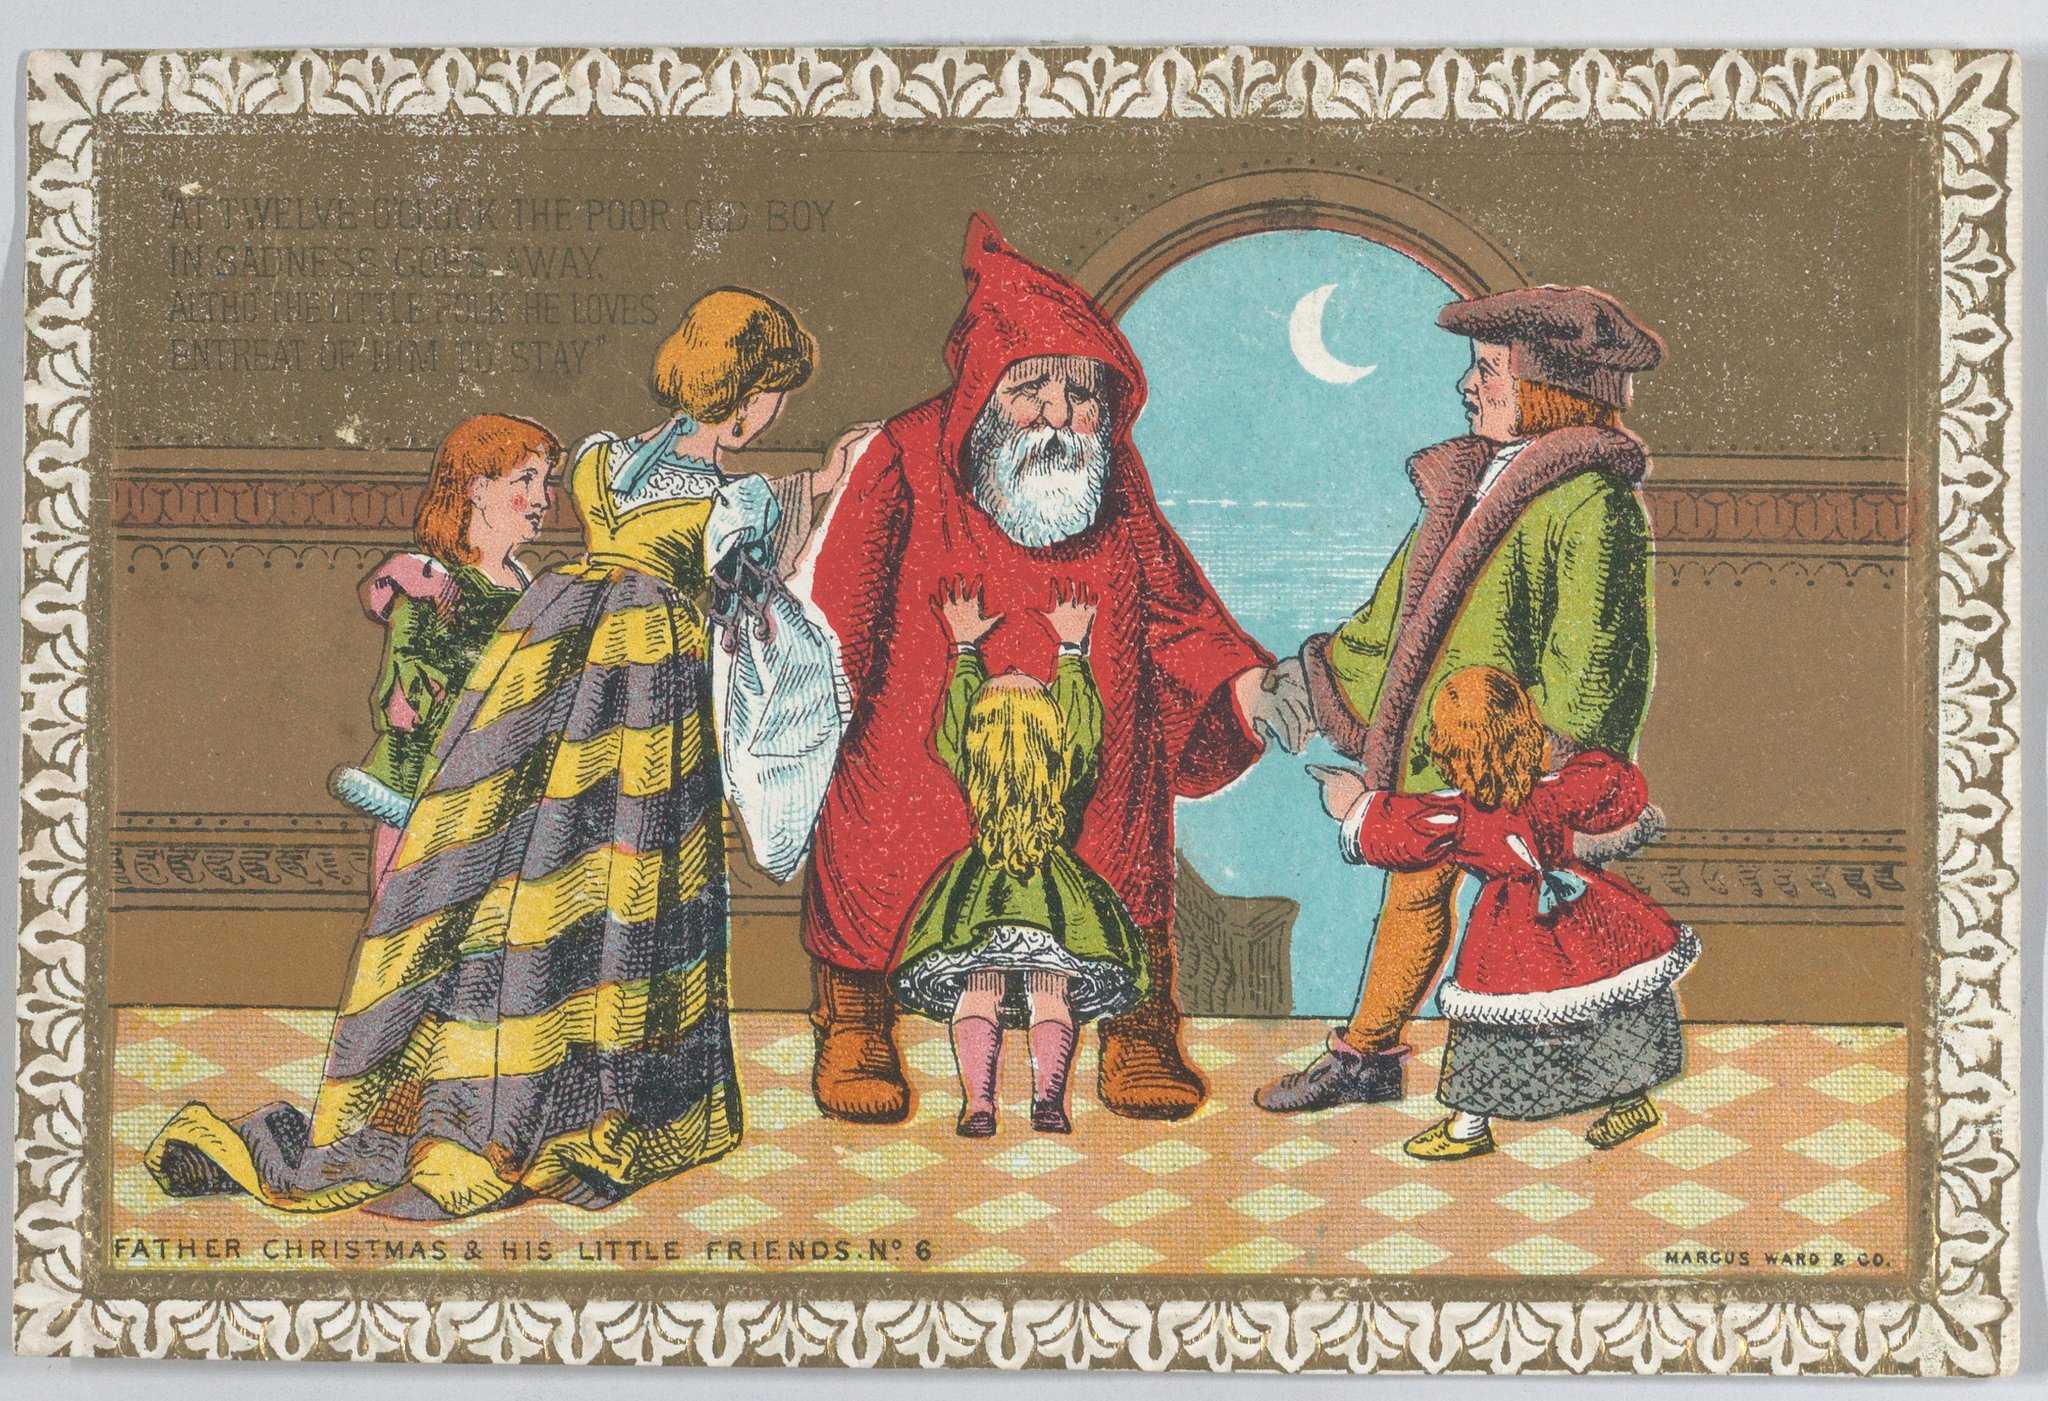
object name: valentine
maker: Anonymous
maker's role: artist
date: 1880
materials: gold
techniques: chromolithography, lithograph